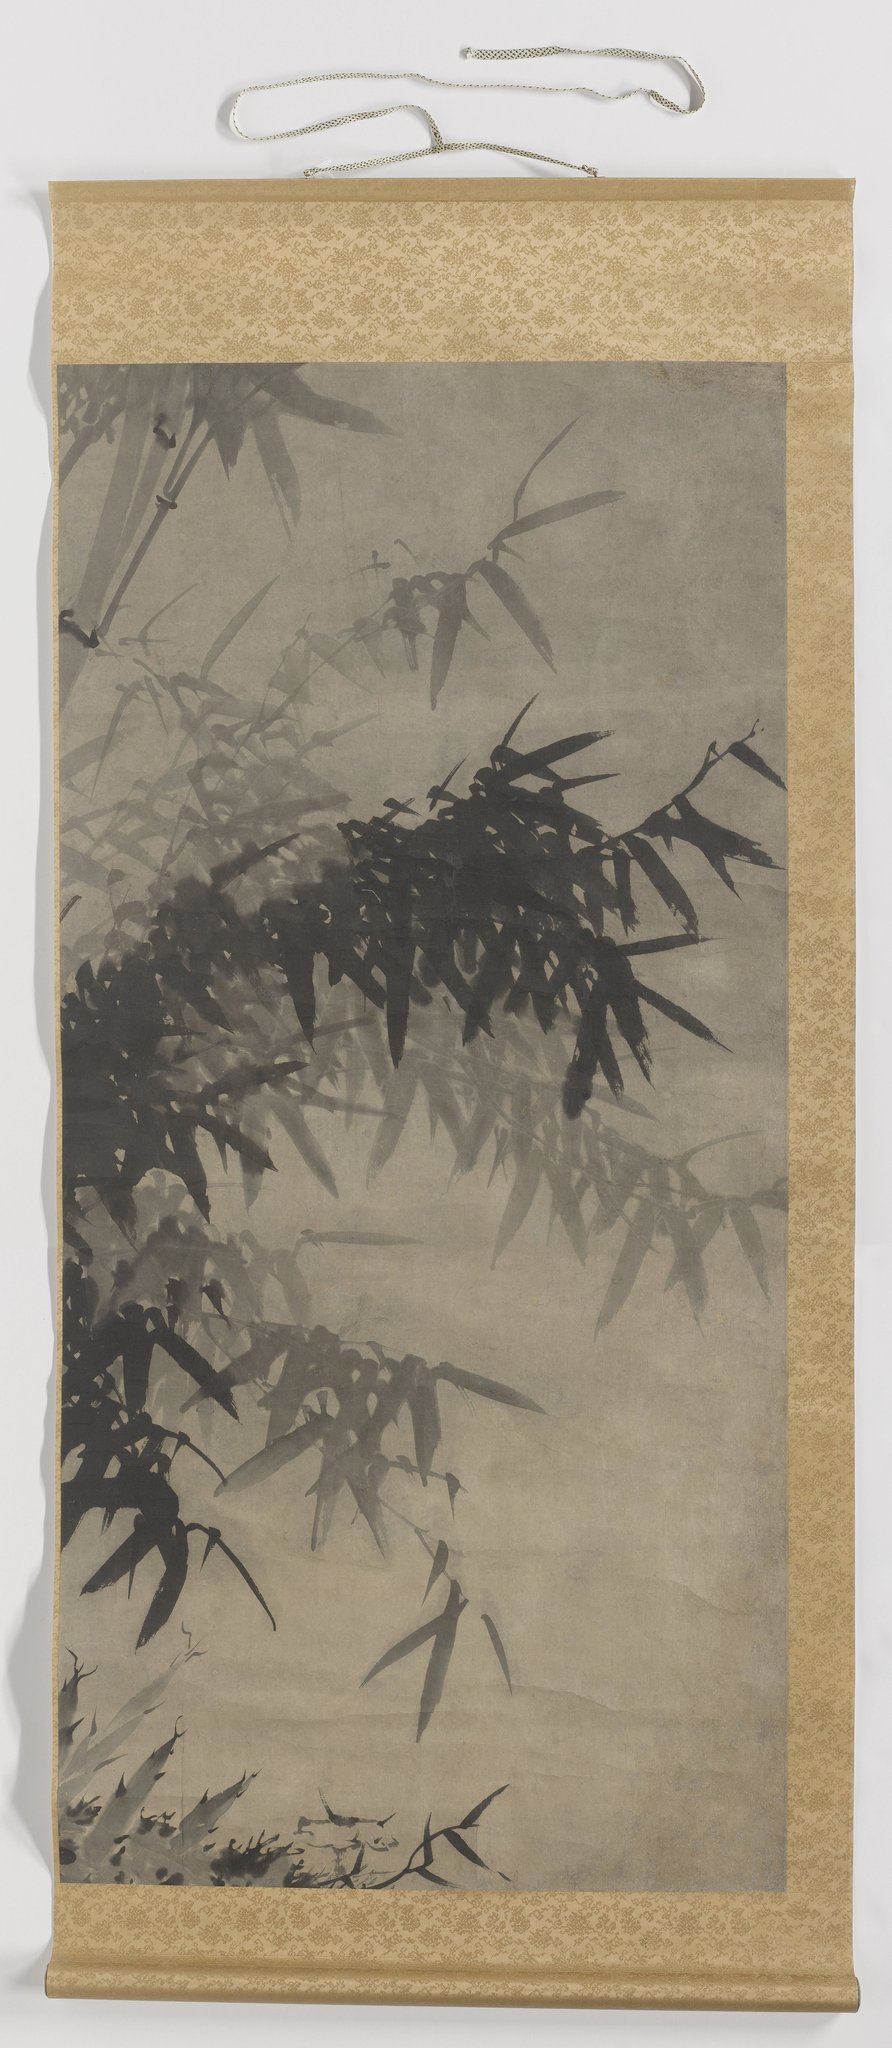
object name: hanging scroll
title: Bamboo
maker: zhengxing (bijnaam wuzhai)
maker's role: painter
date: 1675-1750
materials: ink, paper, silk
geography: china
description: These four hanging scrolls are examples of Chinese bamboo painting. Central to this genre is mastery of the brush. The bamboo stem segments as well as the individual leaves are all rendered with just a single brushstroke. The artist worked fairly wet and, in addition to grey tints, made ample use of an undiluted deep black ink to create an atmosphere of lush and moist vegetation.